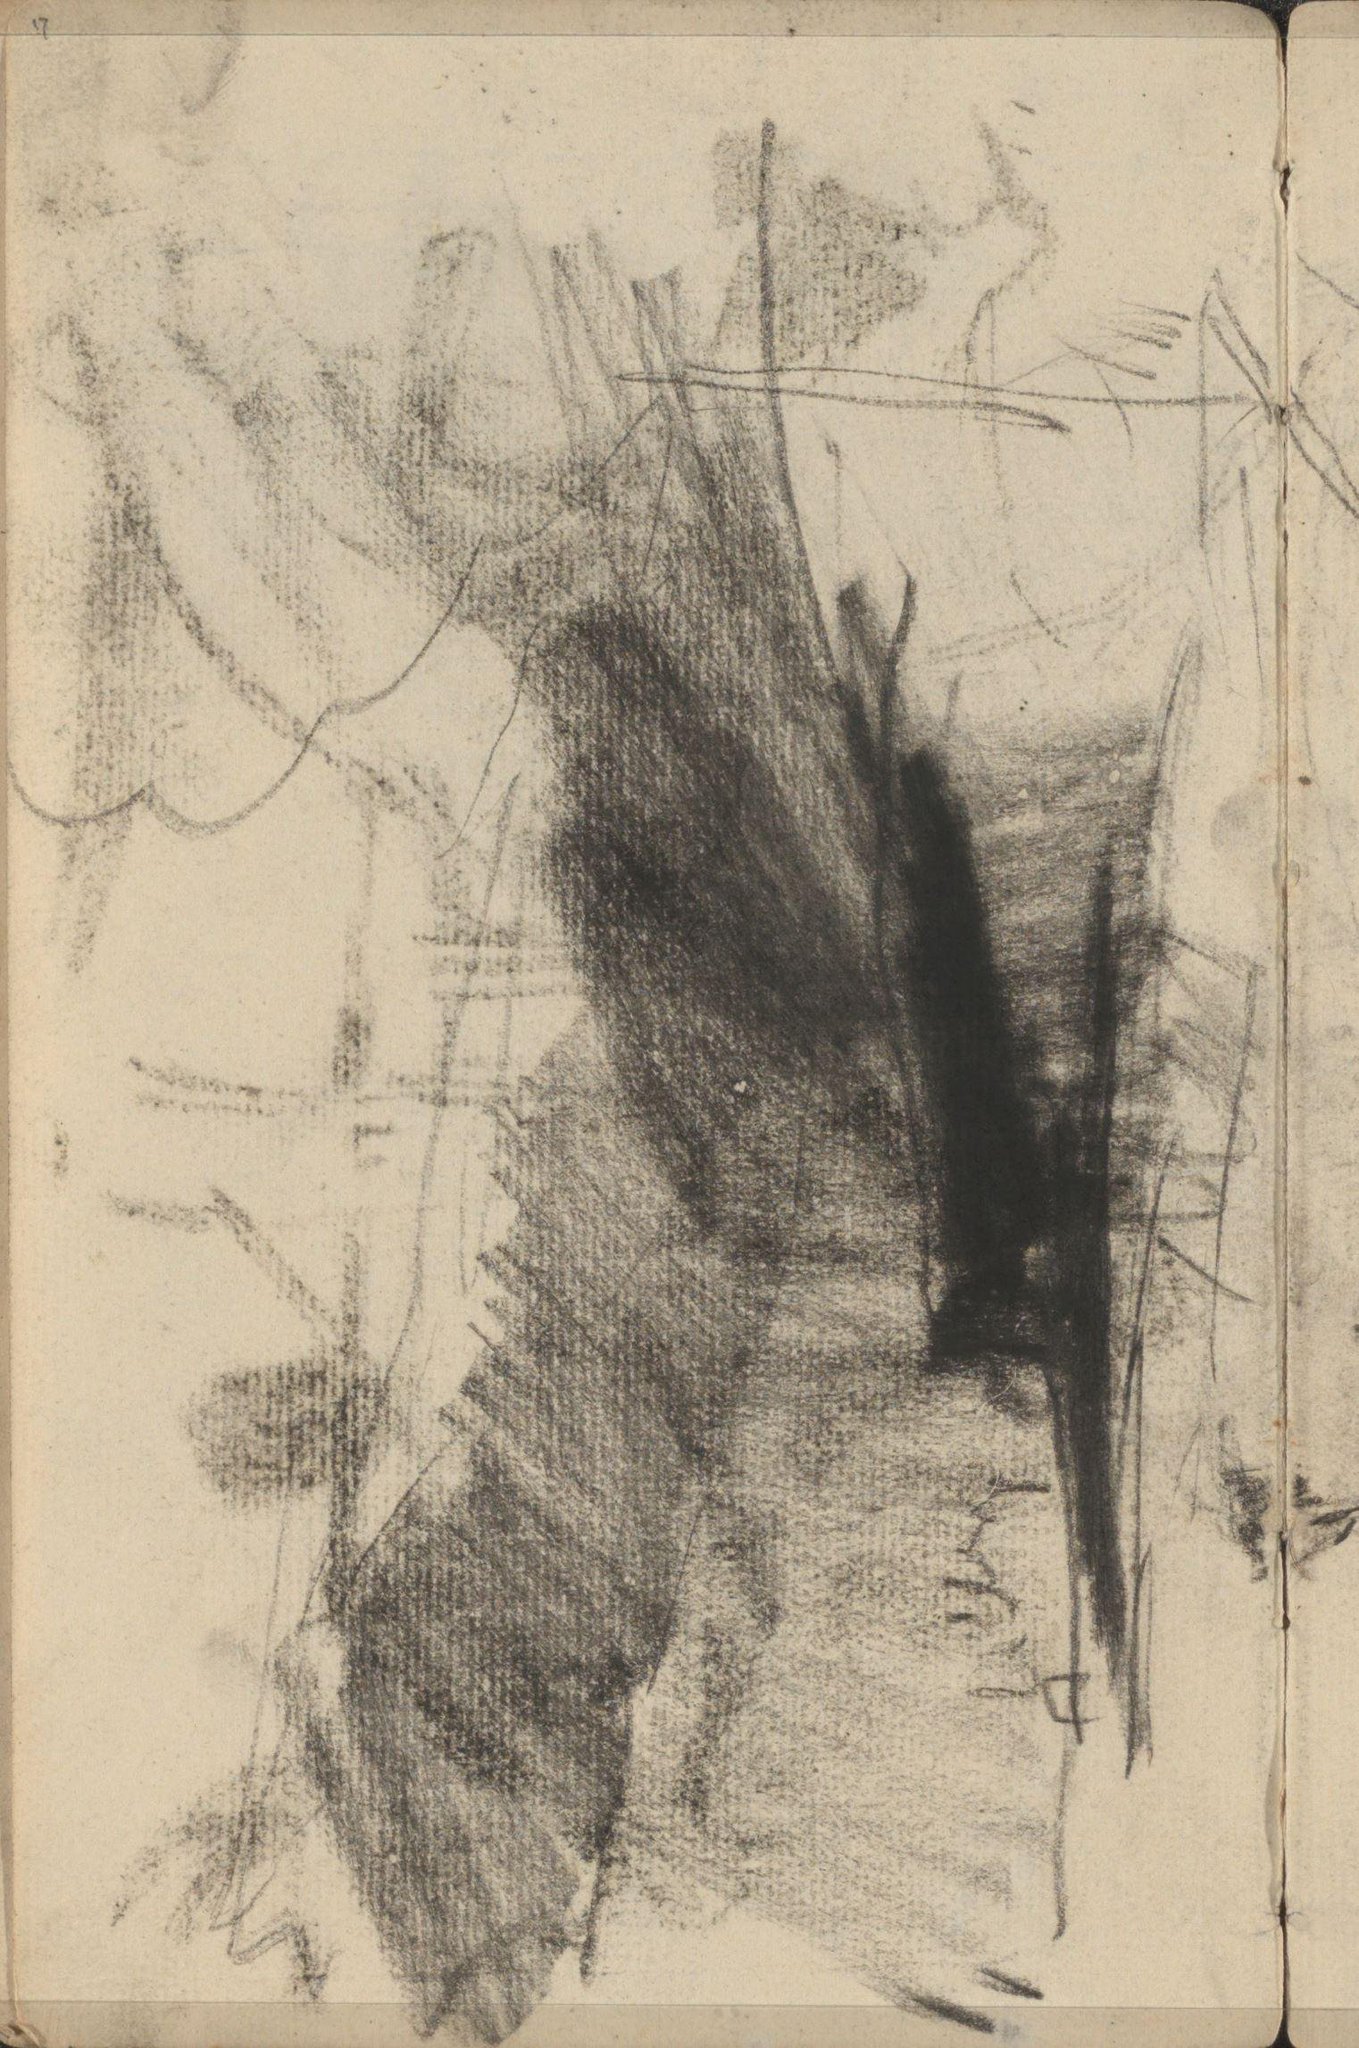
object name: sketchbook leaf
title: Studie, mogelijk van een landschap met wolkenlucht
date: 1883-1885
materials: chalk, paper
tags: landscapes, clouds, rural housing, e.g. country-house, villa, cottage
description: Pagina 17 uit een schetsboek met 16 bladen.